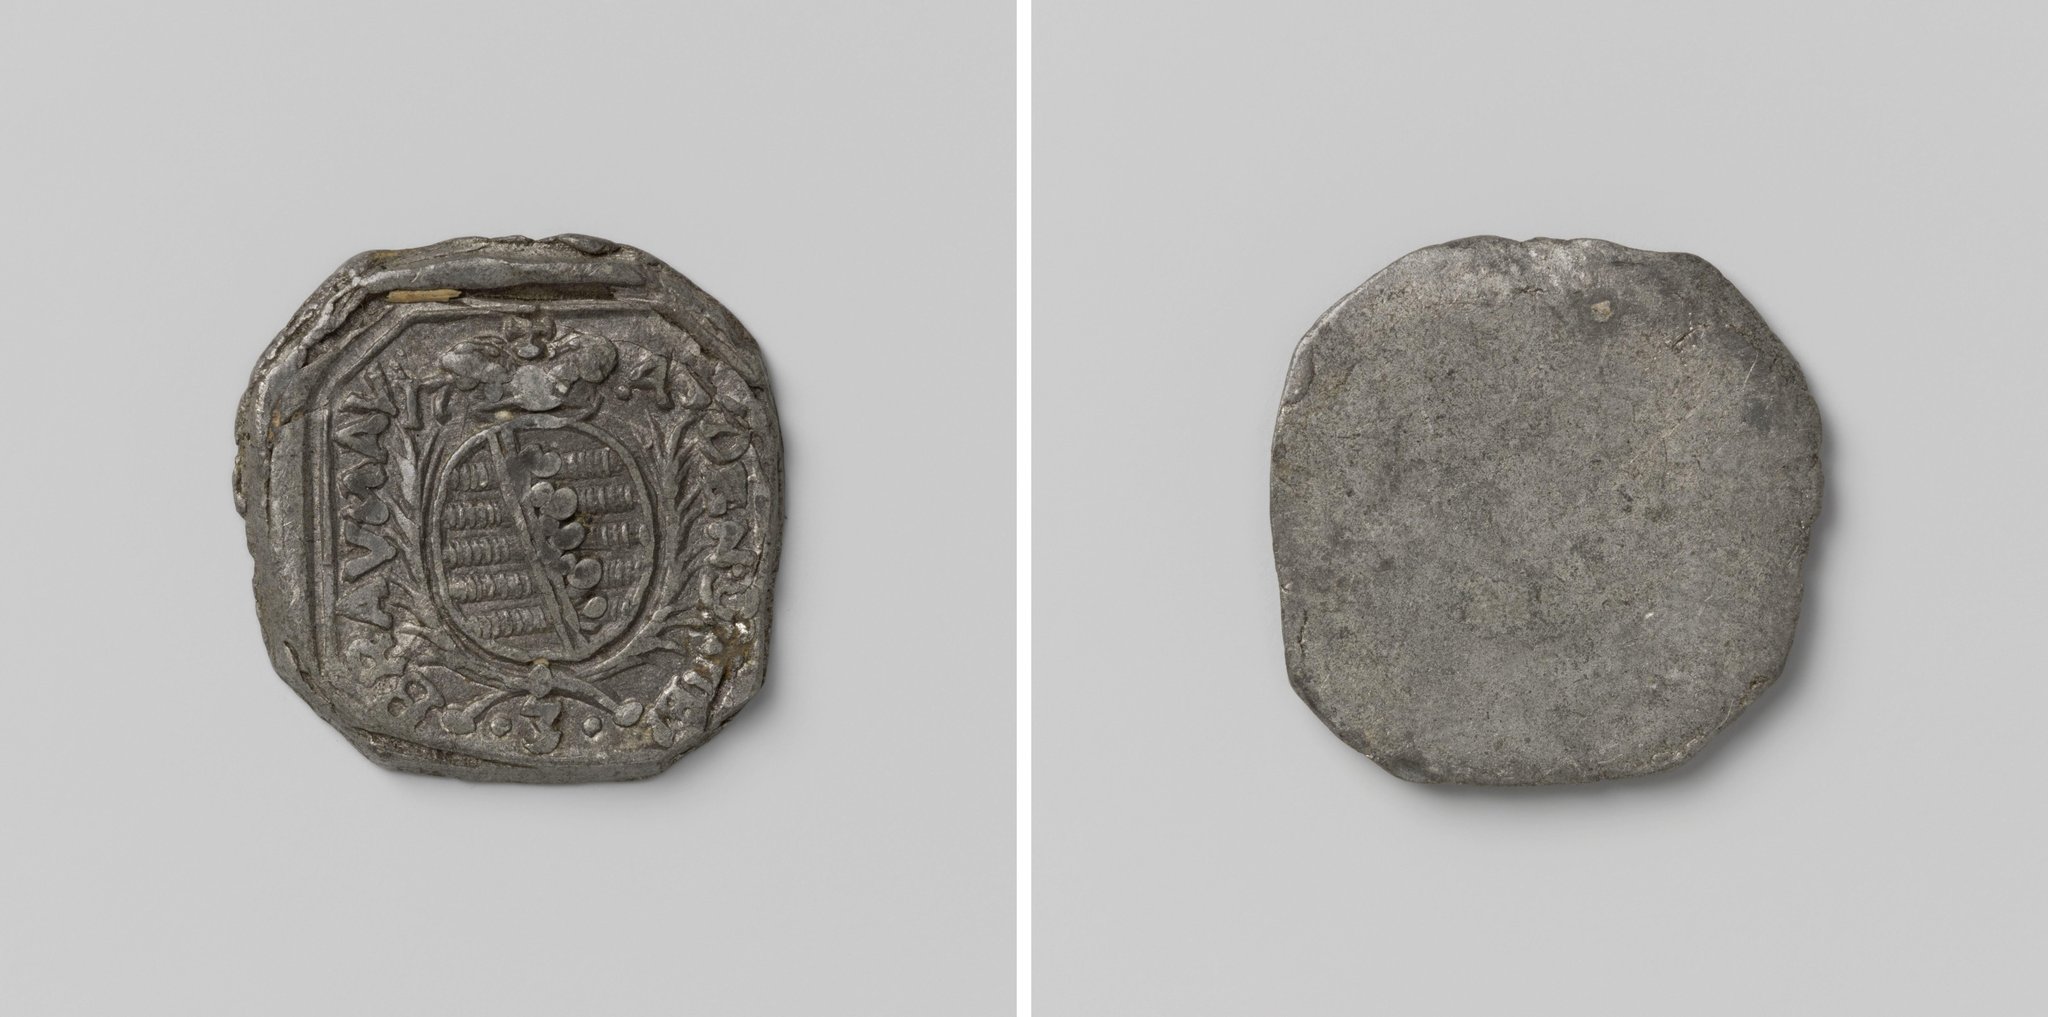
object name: coin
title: Drie kreuzer, noodmunt uit Braunau, geslagen tijdens het beleg door de Oostenrijkers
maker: Anonymous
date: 1743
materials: tin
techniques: striking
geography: braunau-am-inn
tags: braunau-am-inn, beleg van braunau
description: Eenzijdige, vierkante tinnen noodmunt met afgeschuinde hoeken. Voorzijde: gekroond wapenschild tussen jaartal binnen bladerkrans en omschrift; onder wapenschild: waardeaanduiding. Keerzijde: blanco.